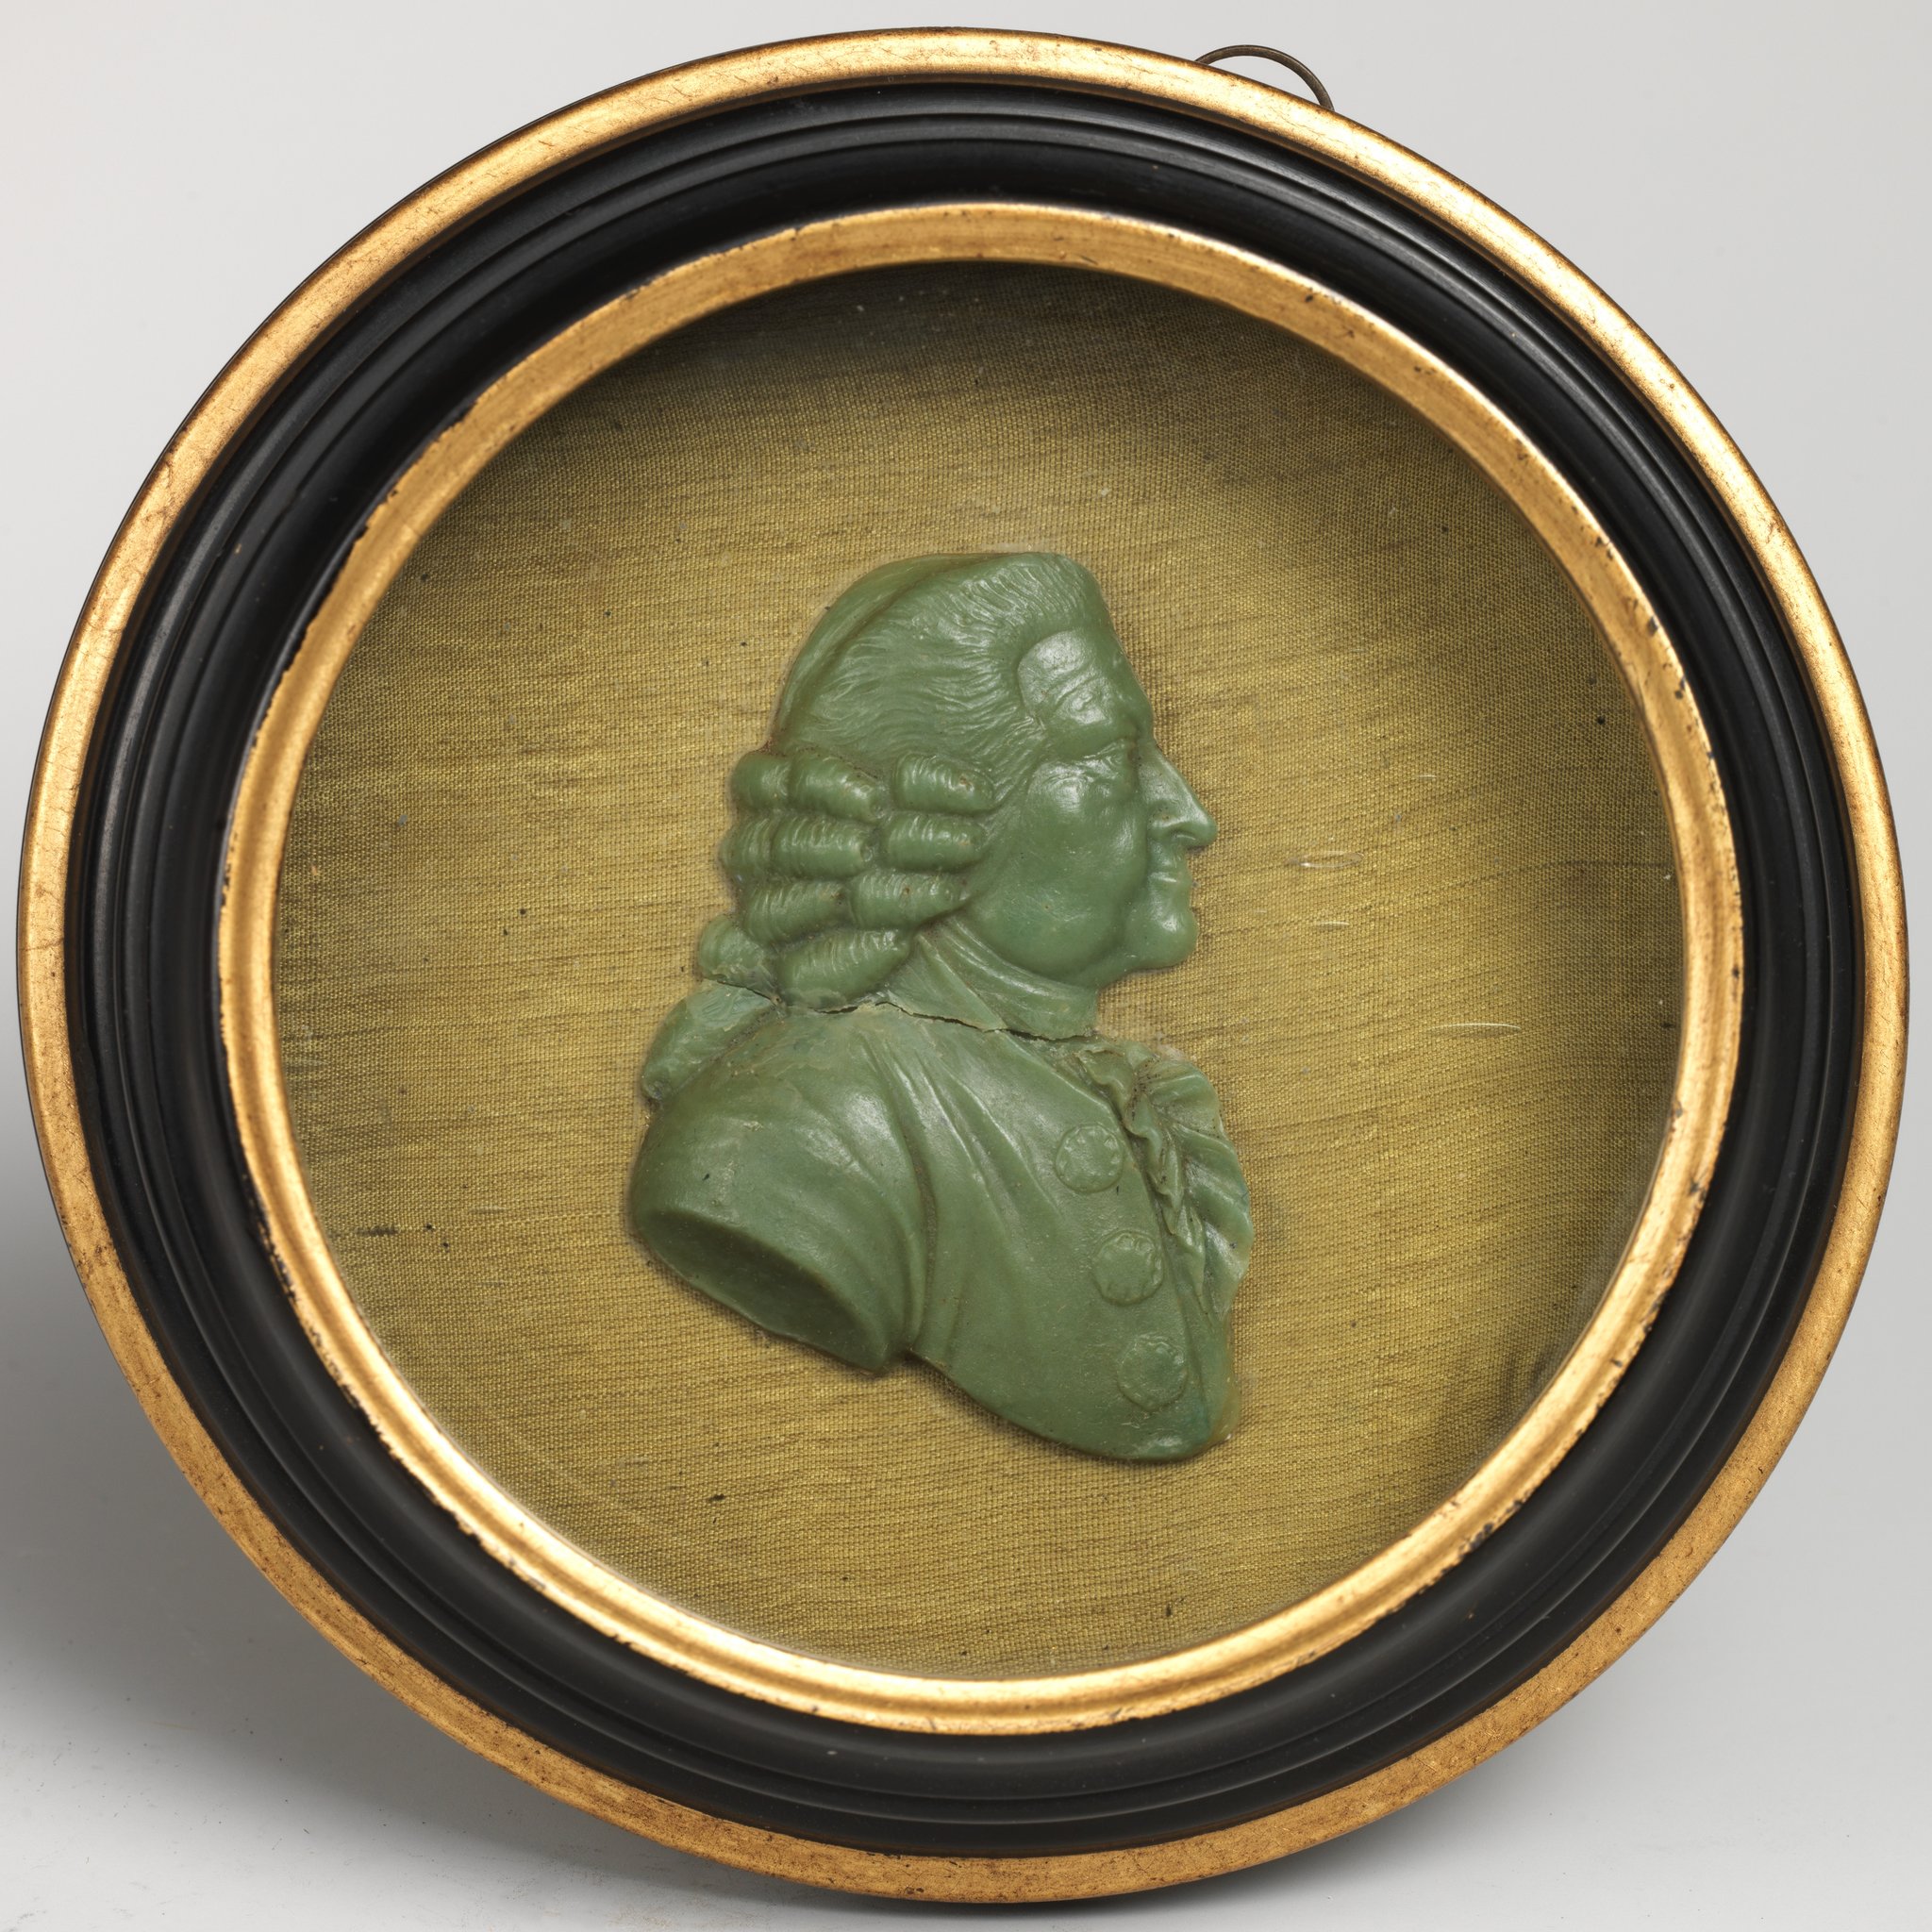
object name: medallion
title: Portrait of a Man (Mirabeau, 1749–1791)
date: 1701-1800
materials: gilt, glass, silk, wax, wood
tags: men,profiles